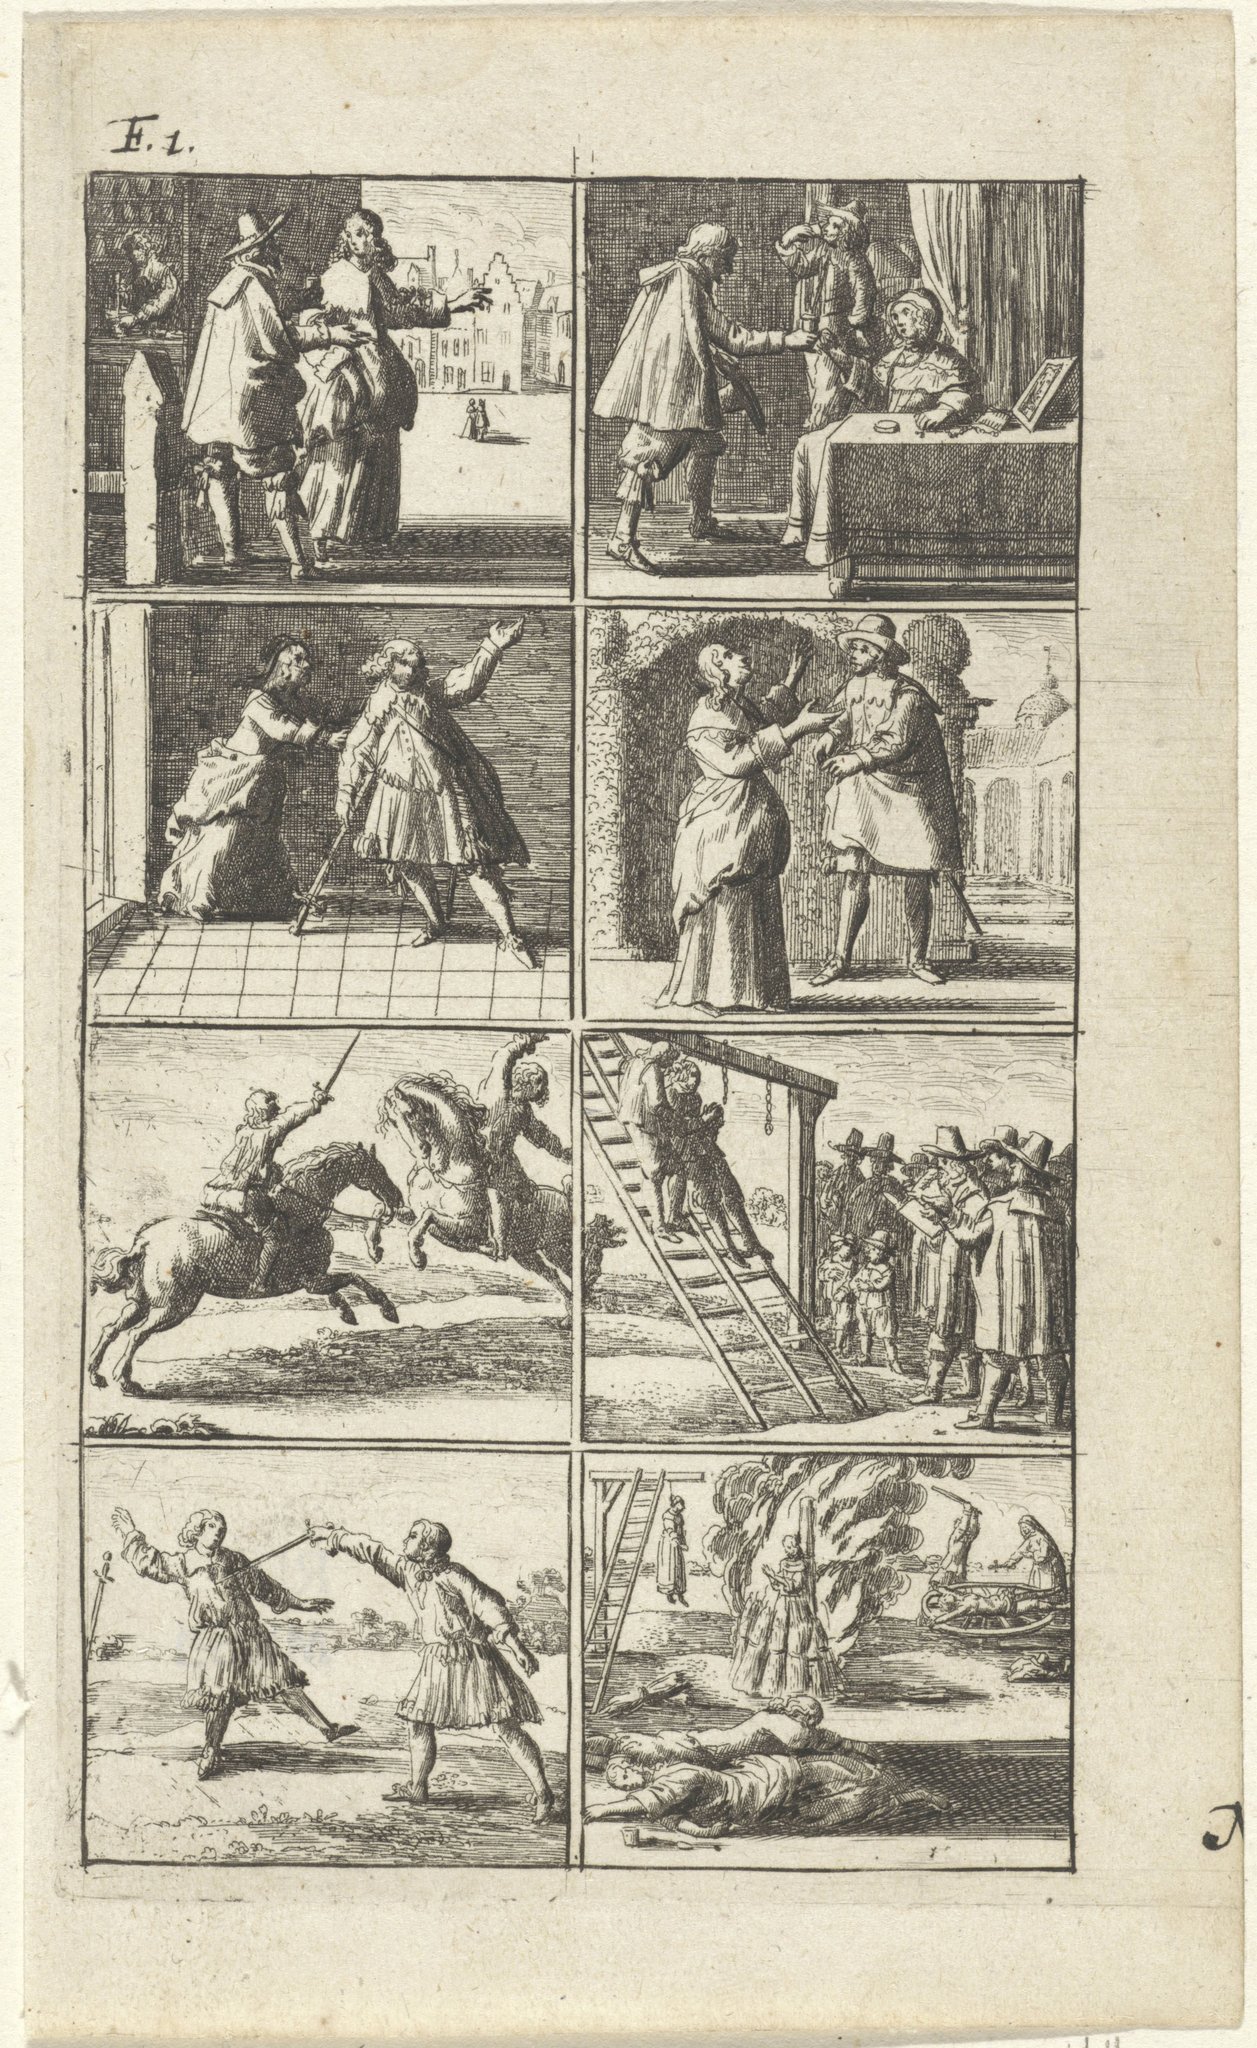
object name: book illustration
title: Verhaal met voorstellingen van moord en doodstraf (F.1.)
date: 1667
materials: paper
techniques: etching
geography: amsterdam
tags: death penalty, execution, murder, fighting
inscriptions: collector's mark: Lugt 2166, collector's mark: Lugt 2760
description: Verhaal in acht scènes met enkele voorstellingen van moord en doodstraf. Onder andere van vechtende ruiters, een man die aan de galg wordt vastgemaakt, een man die iemand doodt met een zwaard, een vrouw op een brandstapel, een vrouw aan een galg en van een vrouw die wordt geradbraakt. Linksboven: F. 1.